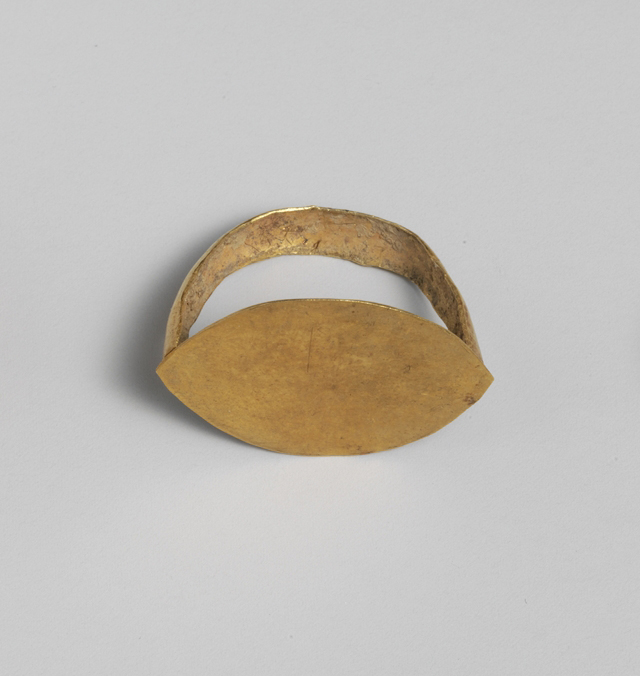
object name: ring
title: Gold ring with elliptical bezel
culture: etruscan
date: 300-301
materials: gold